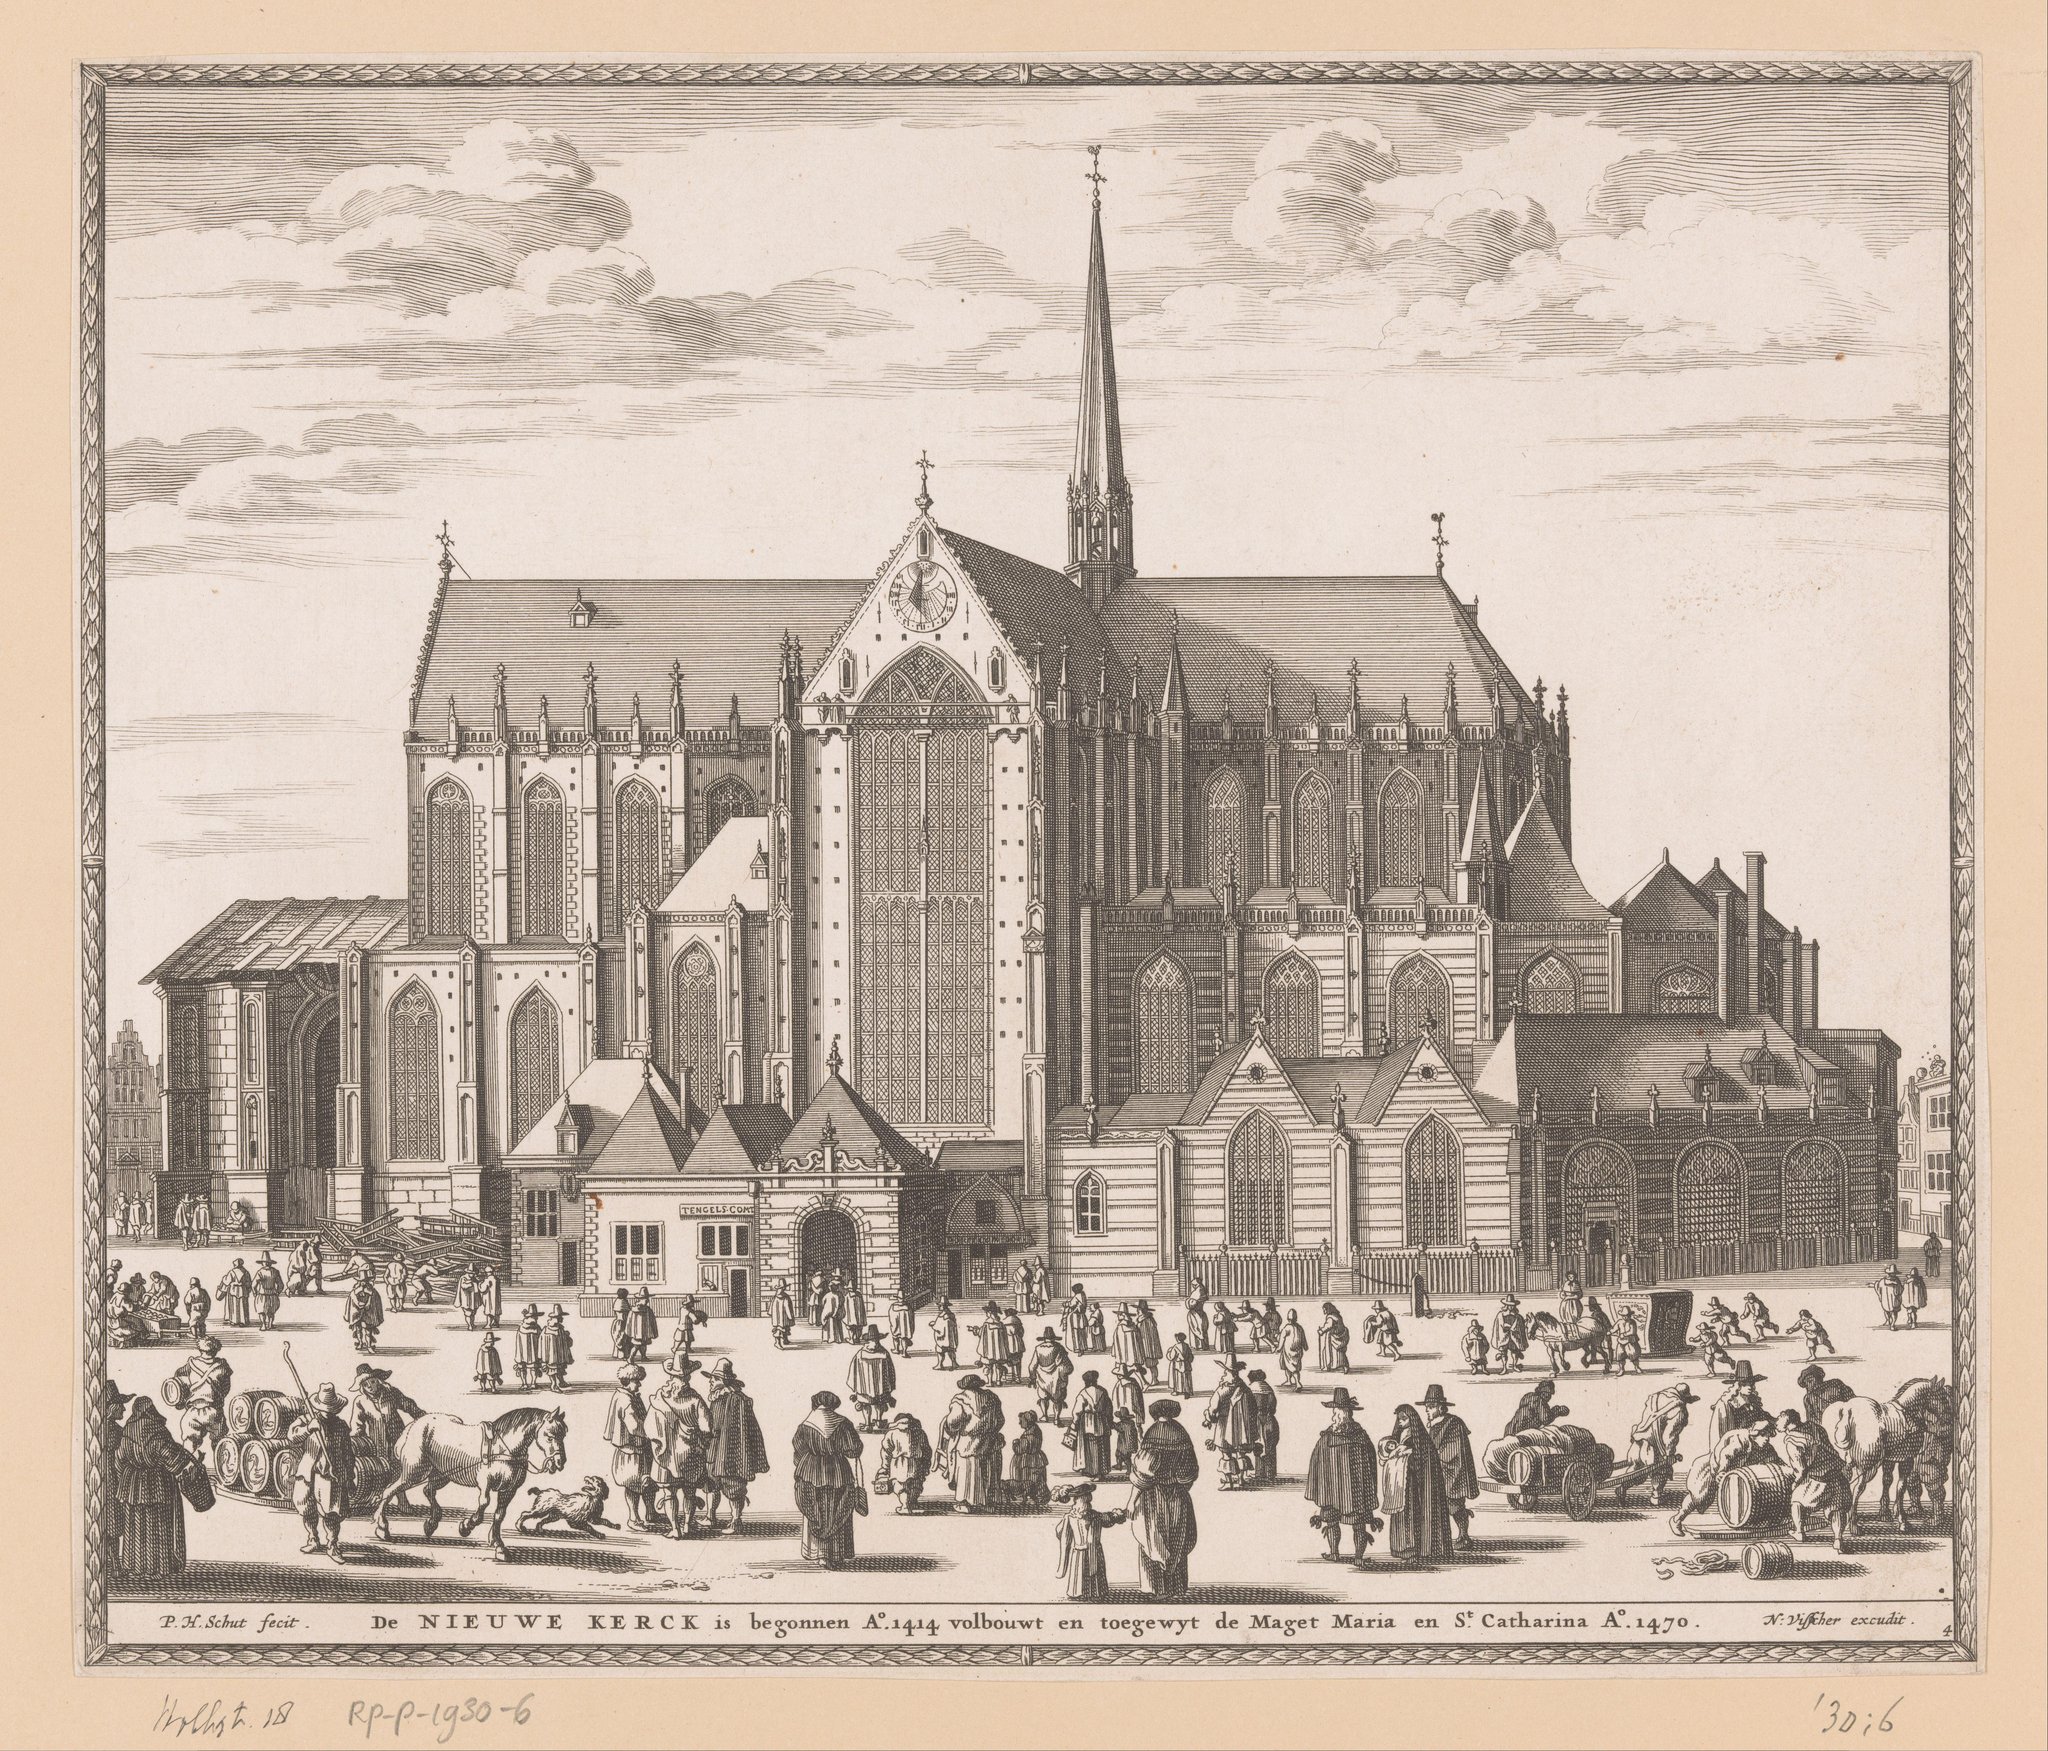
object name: print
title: Gezicht op de Nieuwe Kerk te Amsterdam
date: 1662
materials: paper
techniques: etching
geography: amsterdam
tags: church (exterior), city-view, and landscape with man-made constructions (+ city(-scape) with figures, staffage)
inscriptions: collector's mark: Lugt 2233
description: Ook uitgegeven als onderdeel van sierrand van een wandkaart van Amsterdam, zie RP-P-AO-20-45. Latere staat (RP-P-1937-1625) uitgegeven door Covens & Mortier.